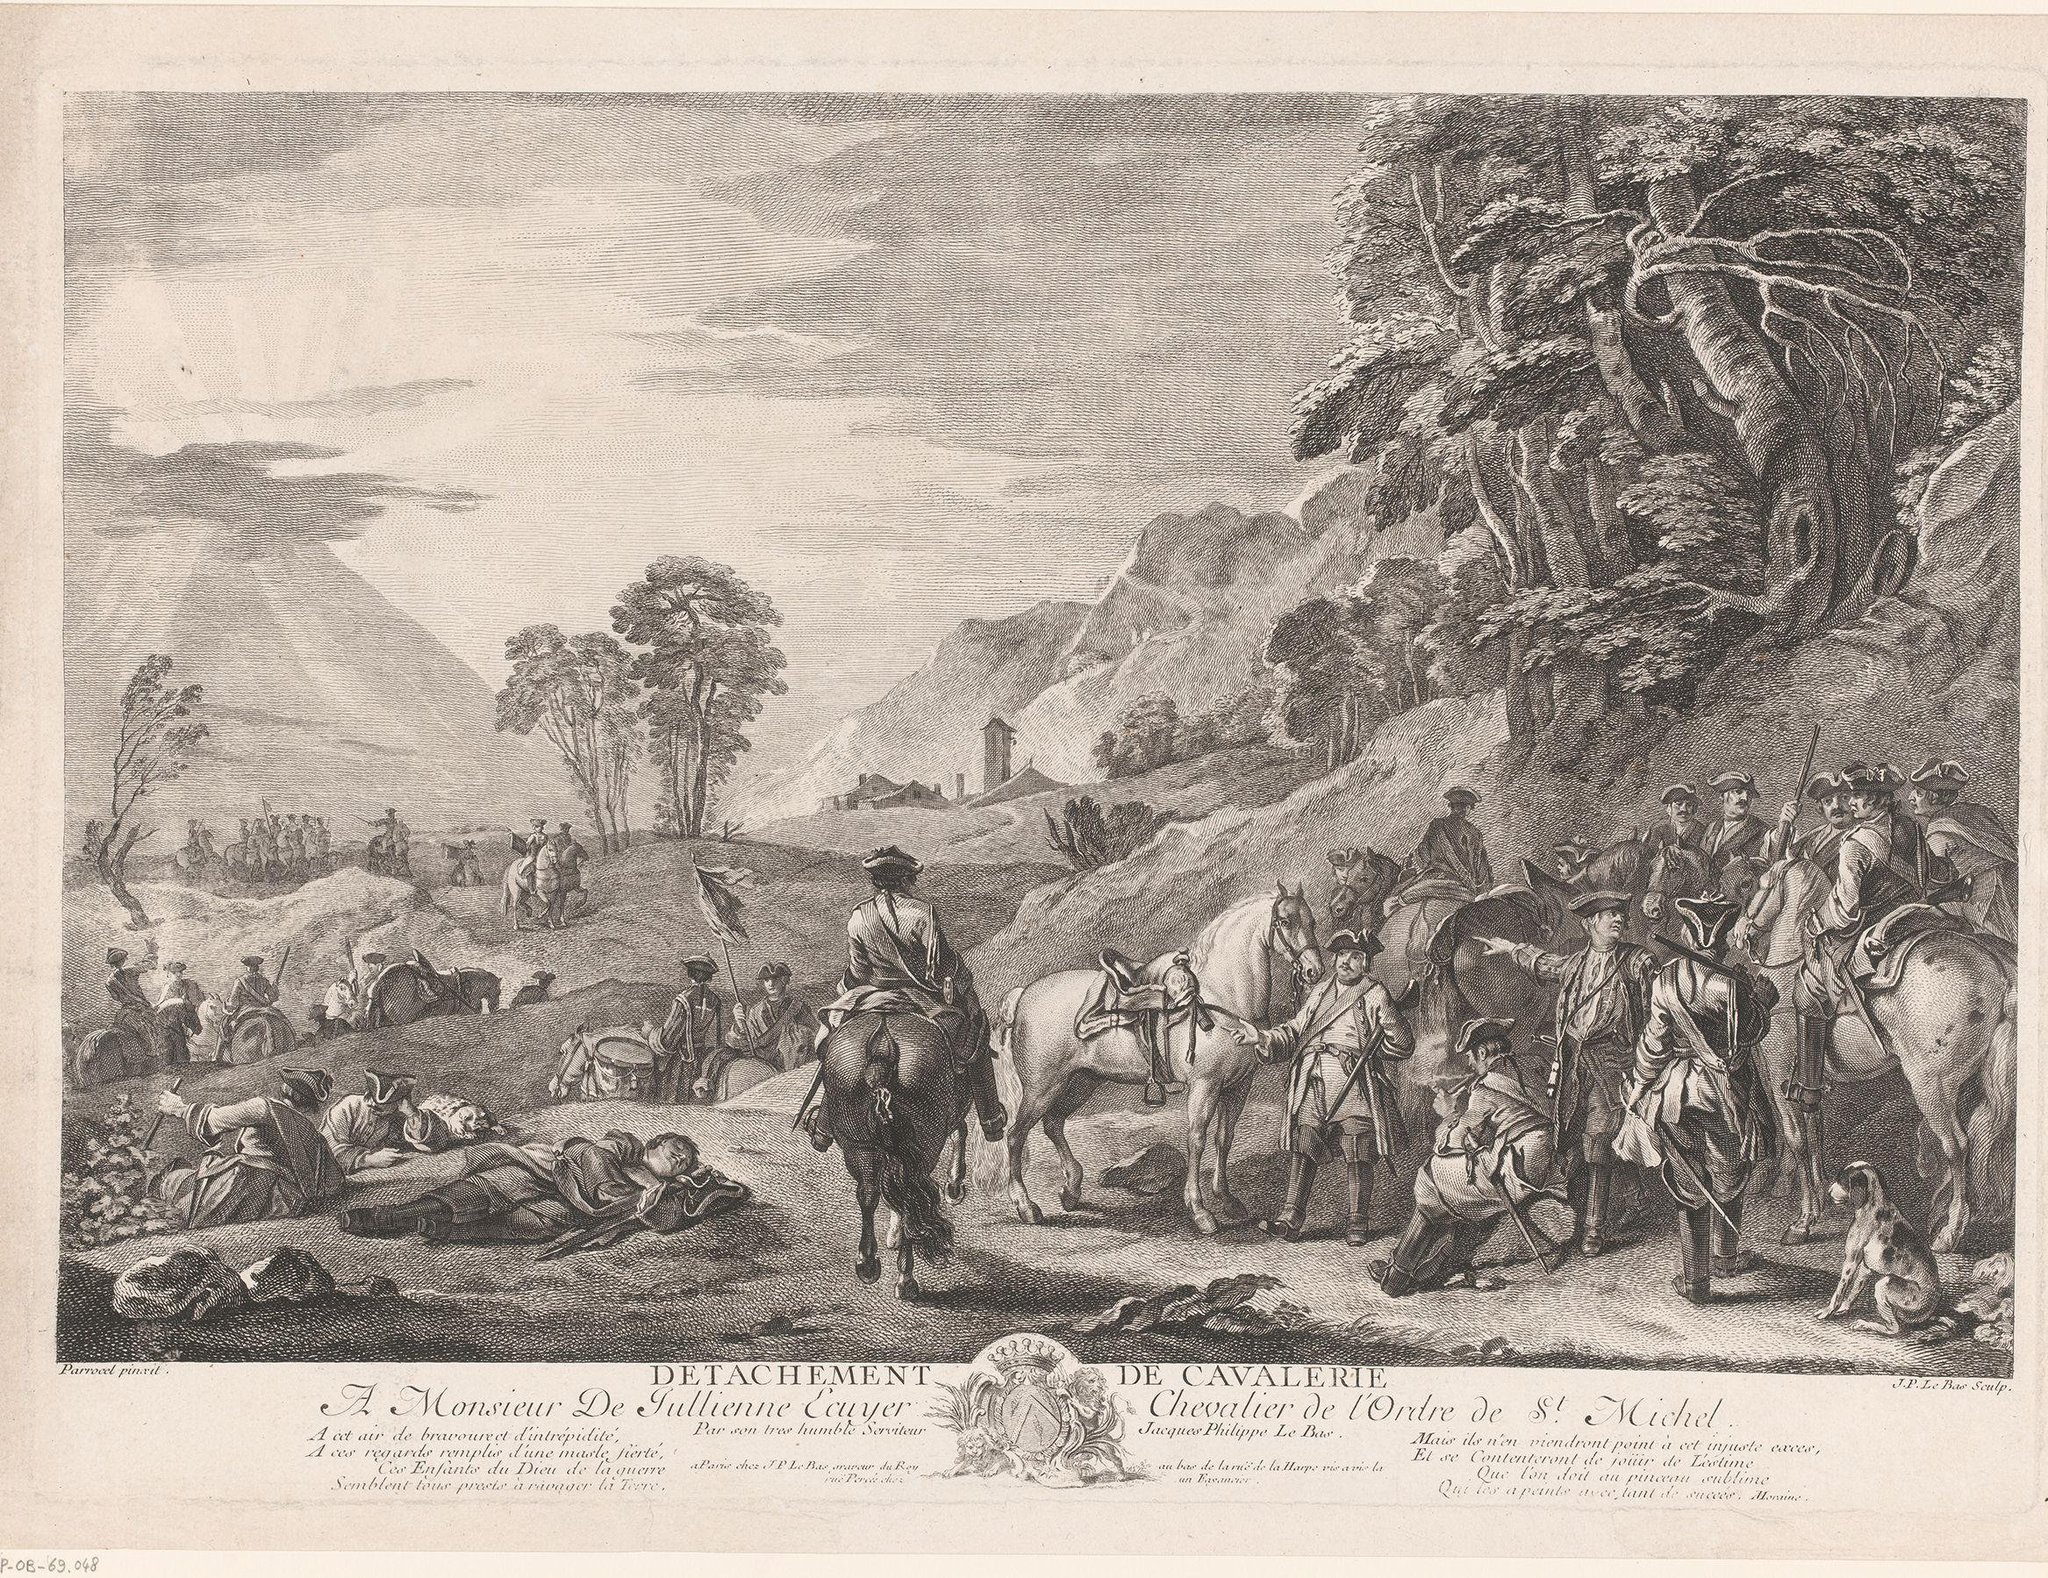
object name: print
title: Landschap met cavalerie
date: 1737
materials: paper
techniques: engraving, etching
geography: paris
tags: battle (+ cavalry, horsemen), the soldier; the soldier's life